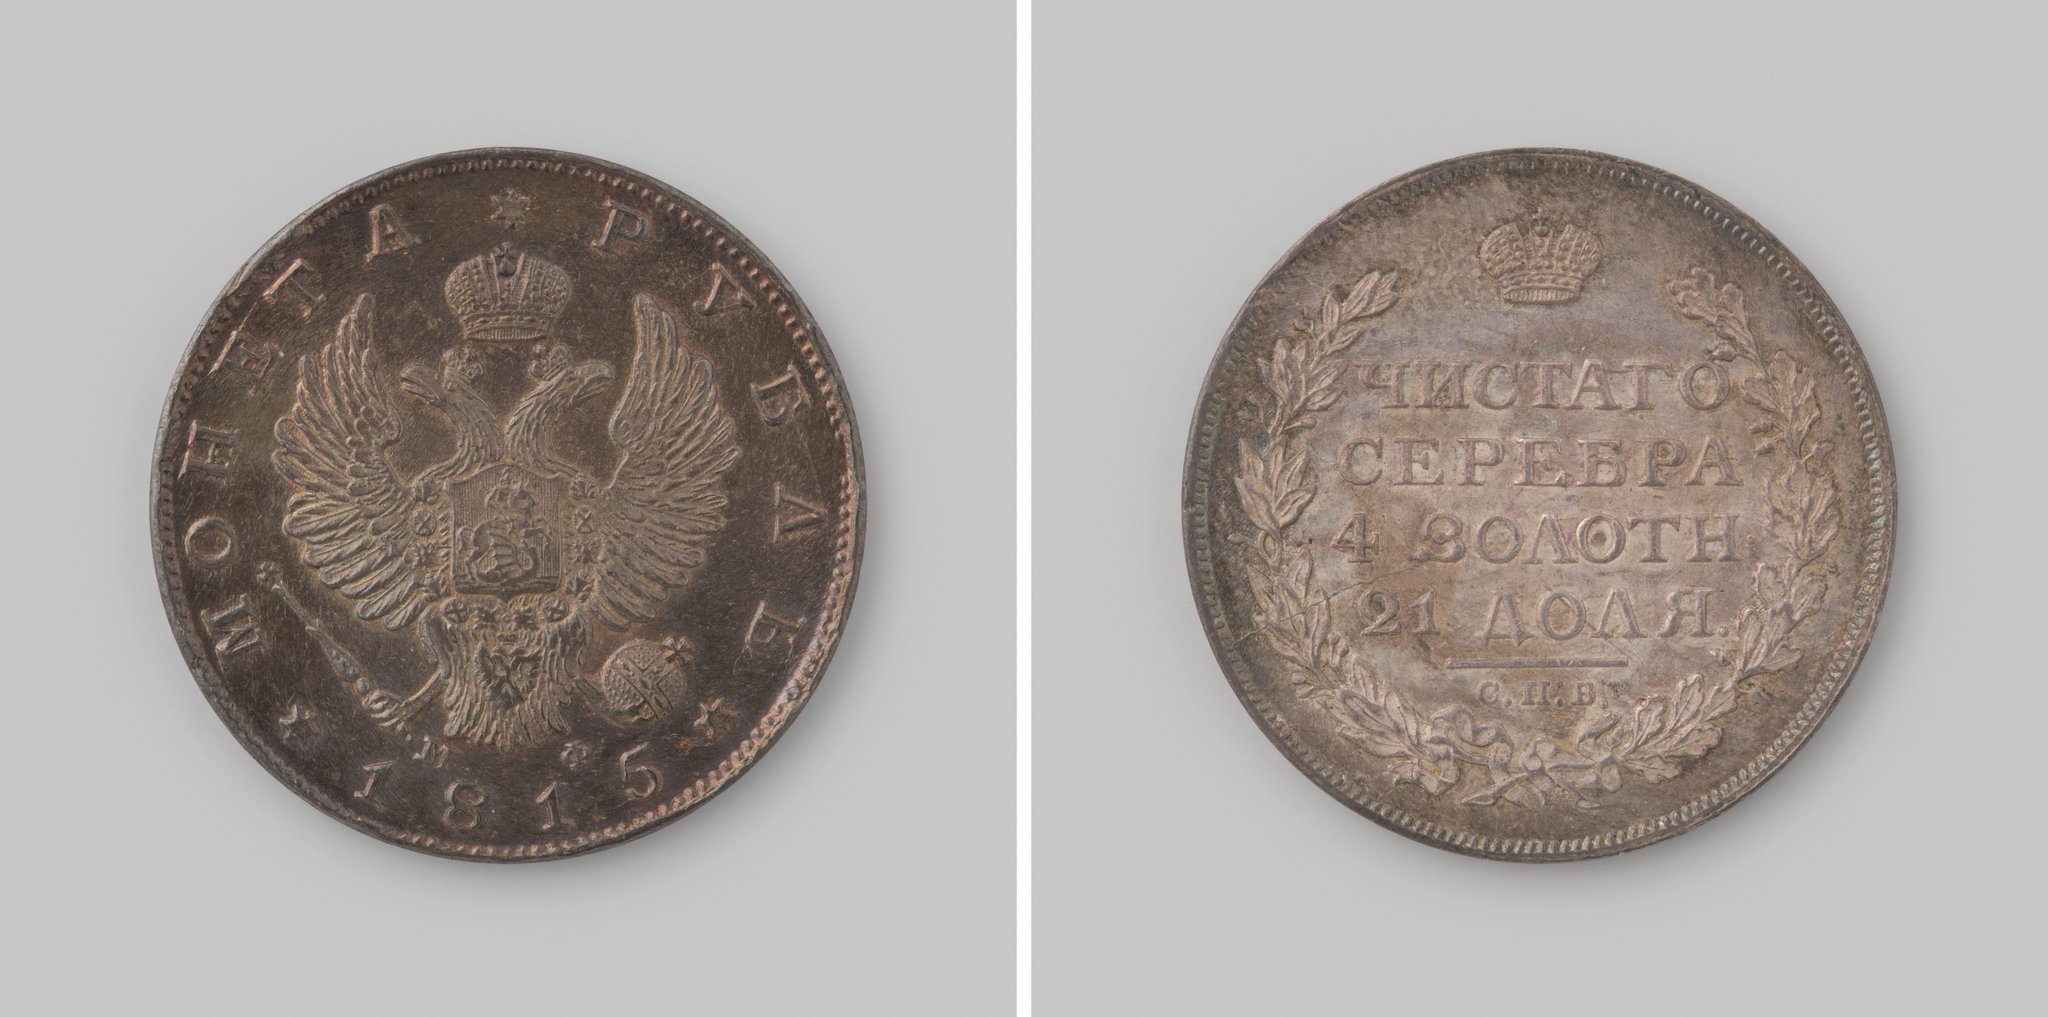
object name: coin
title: Rusland, tsaar Alexander I, roebel, 1815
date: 1815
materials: silver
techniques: striking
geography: sint-petersburg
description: Zilveren munt. Voorzijde: dubbelkoppige gekroonde adelaar met gespreide vleugels, met op zijn borst door ridderorde omhangen wapenschild en met in zijn poten scepter en bol met daarop kruis. Boven de adelaar een kroon. Waarde-aanduiding en jaartal in het omschrift. Keerzijde: binnen twee samengebonden takken onder een kroon opschrift in vier regels. Daaronder de letters S, P en B in Cyrillisch schrift. Randschrift.